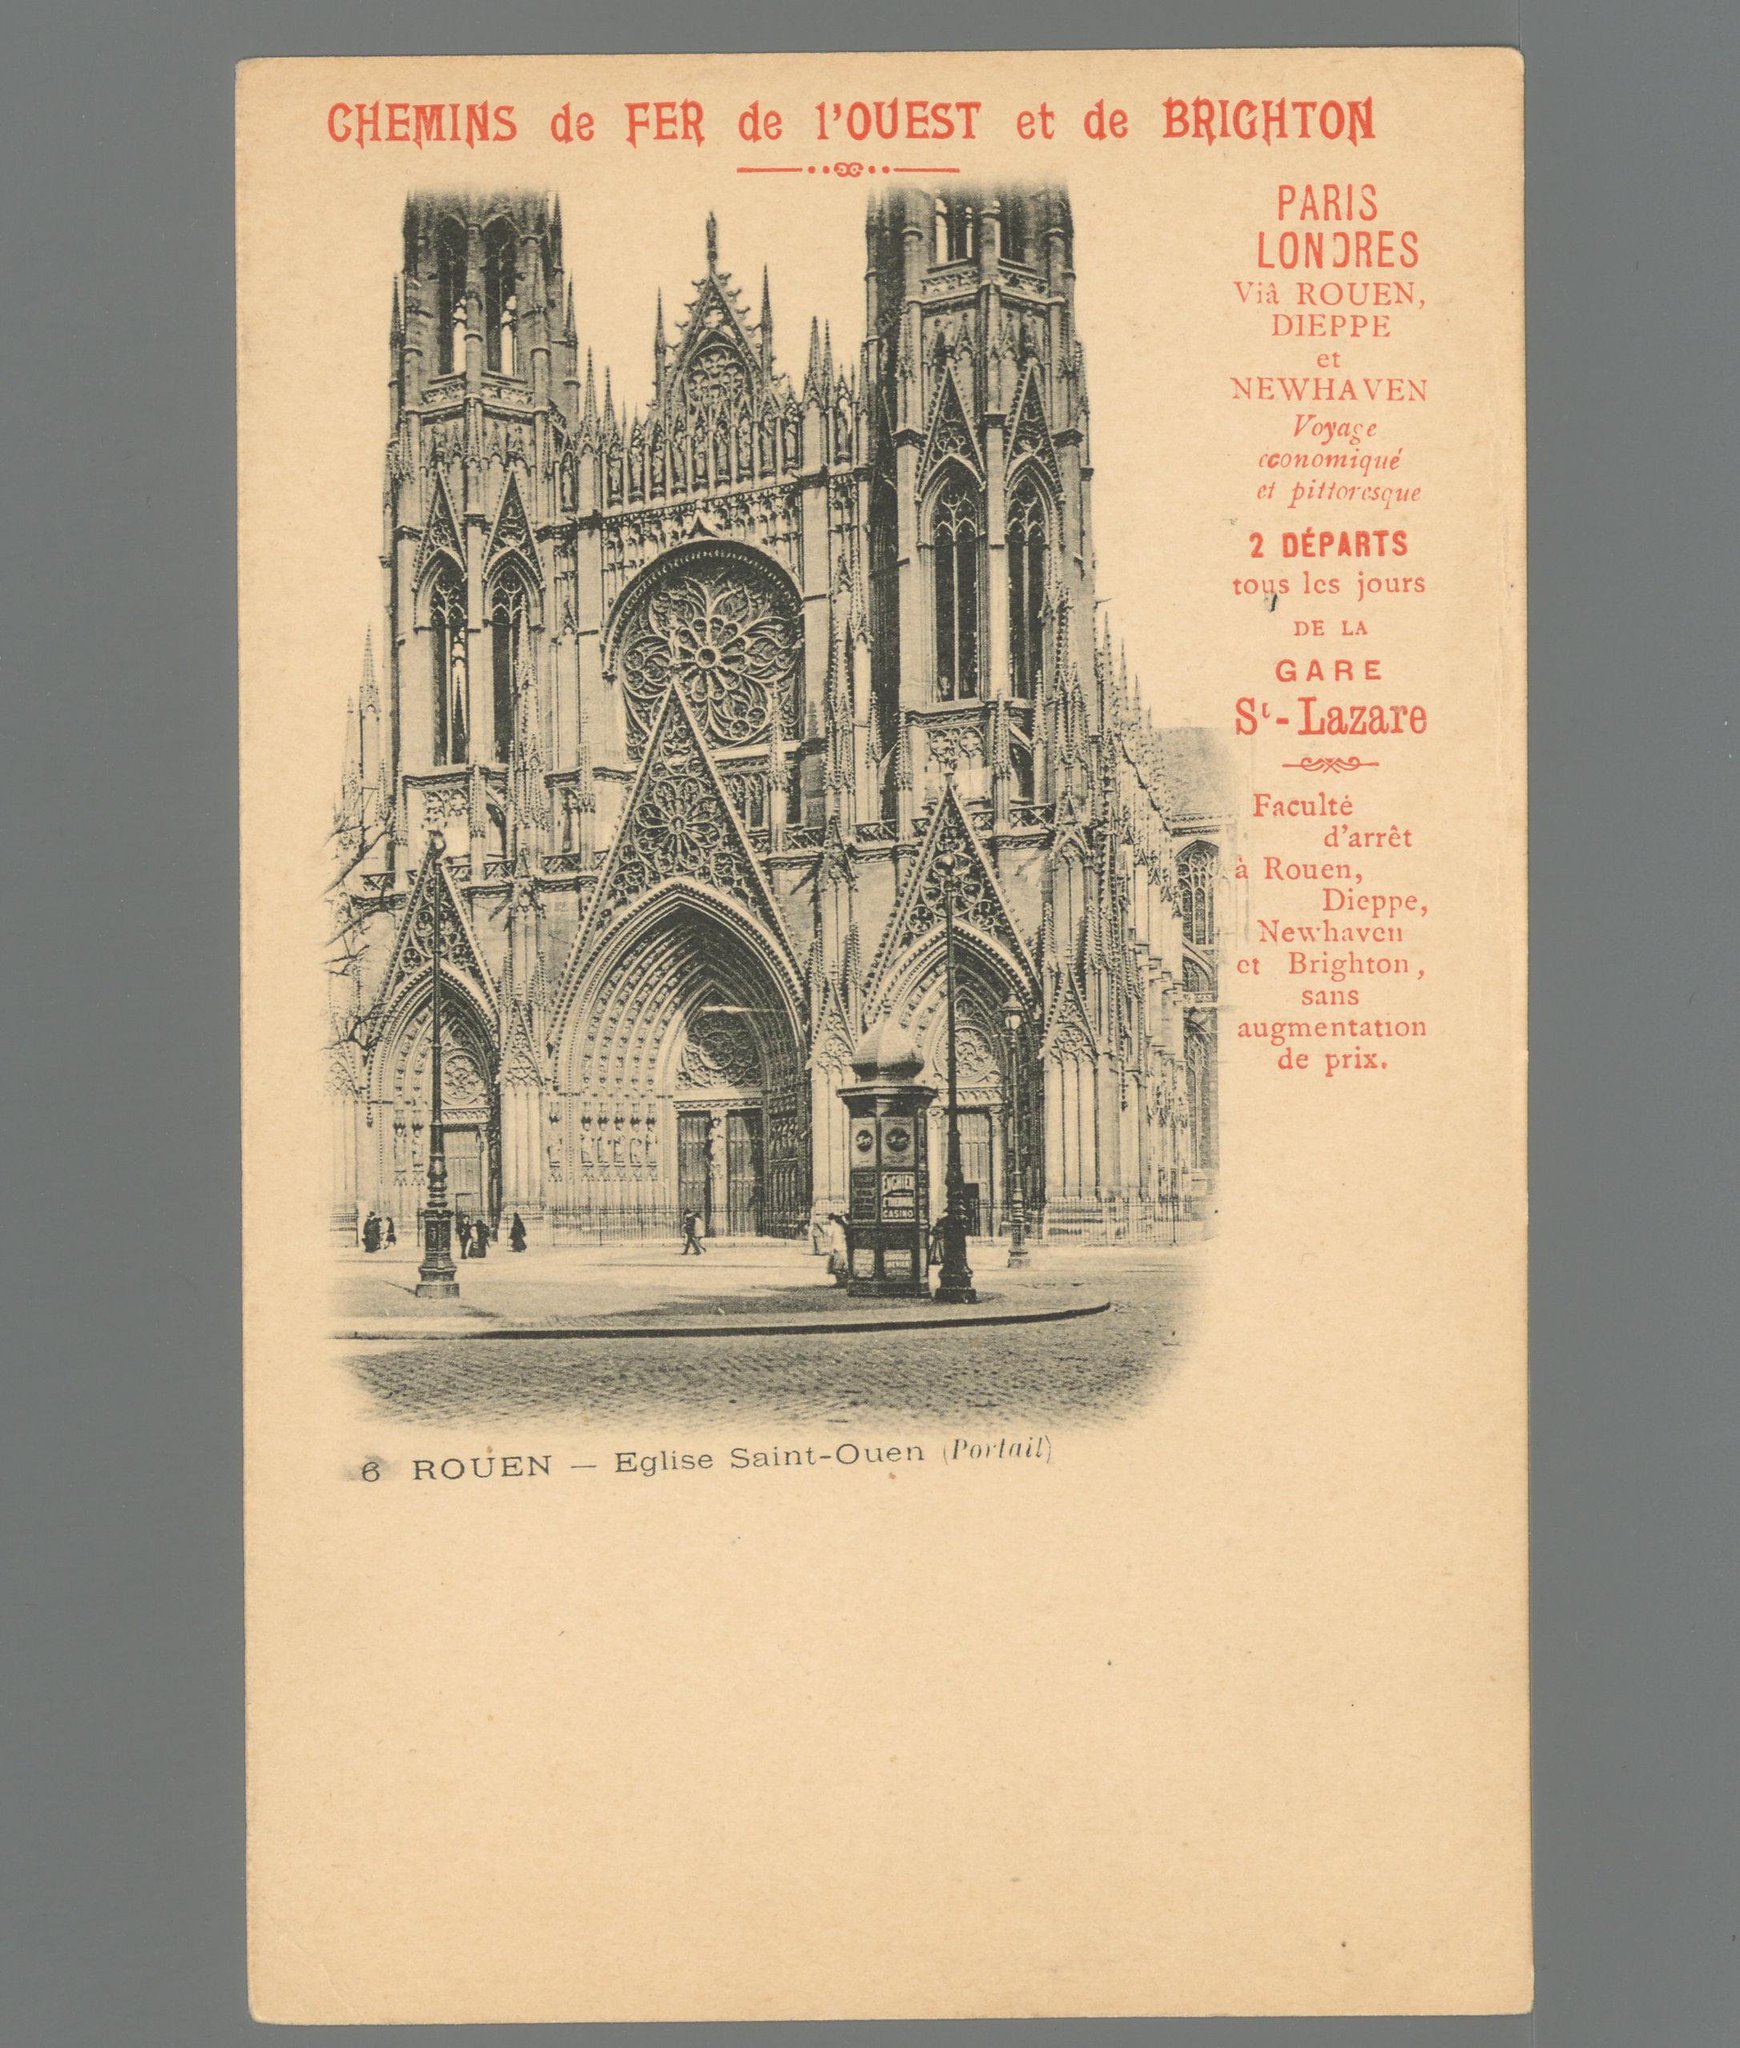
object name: photomechanical print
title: Rouen. Eglise Saint-Ouen (Portail)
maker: Anonymous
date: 1892-1904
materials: cardboard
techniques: photograph, writing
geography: rouen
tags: church (exterior)